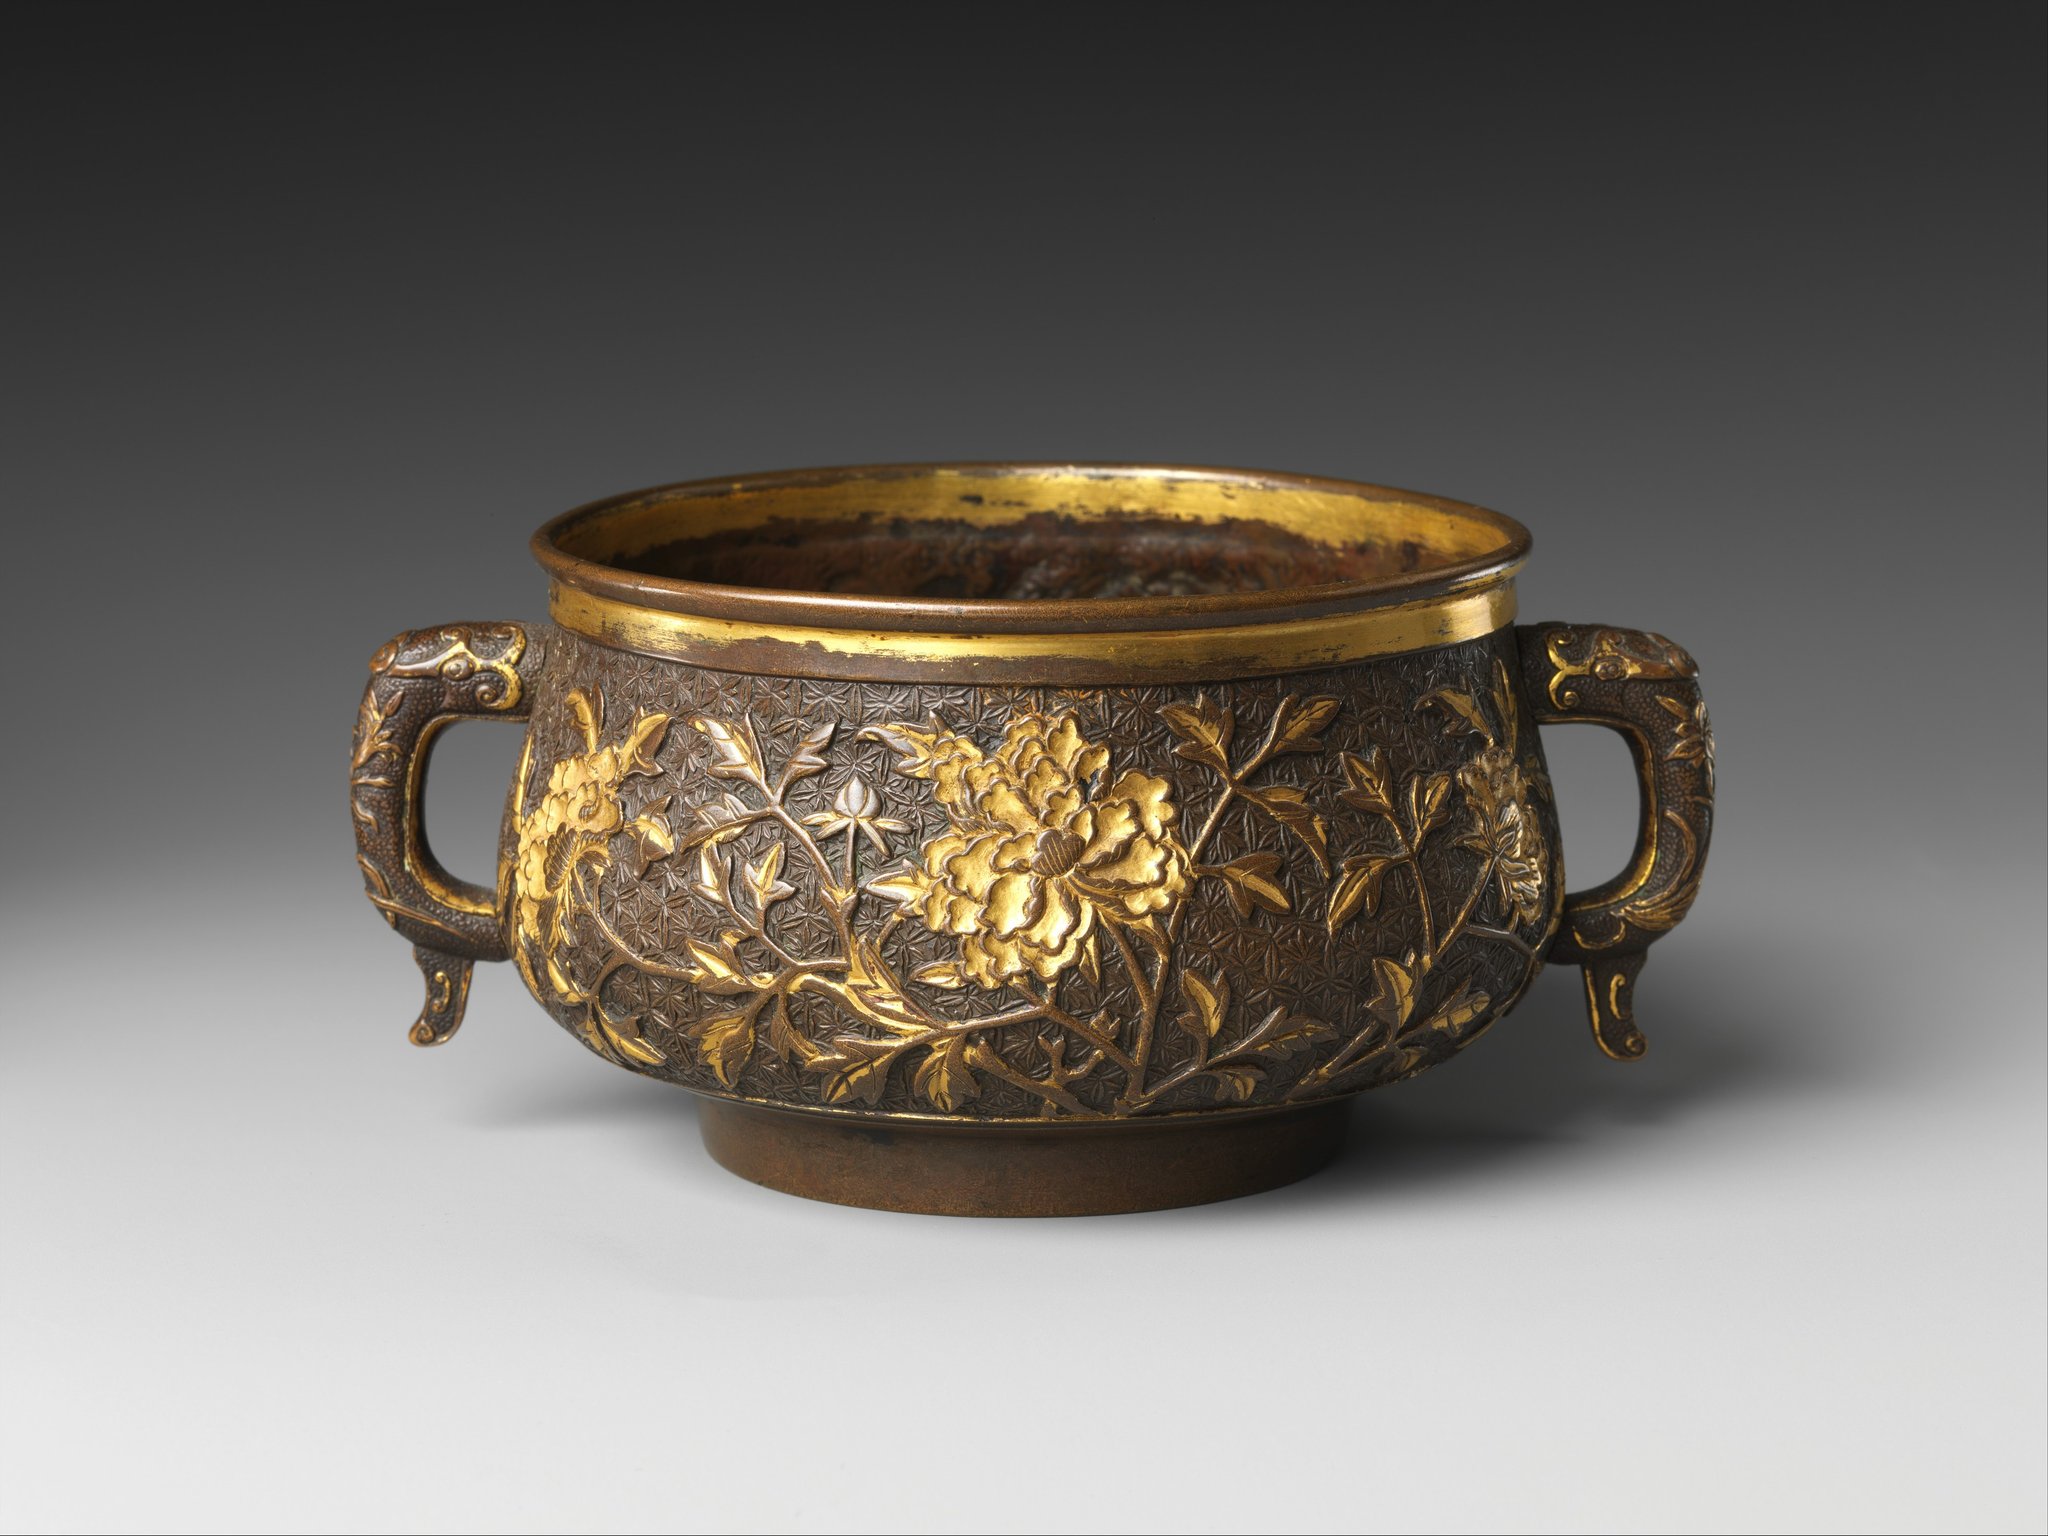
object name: incense burner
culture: chinese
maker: hu wenming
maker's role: artist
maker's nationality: chinese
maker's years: 1550-1650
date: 1601-1700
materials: copper alloy, gilt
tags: flowers